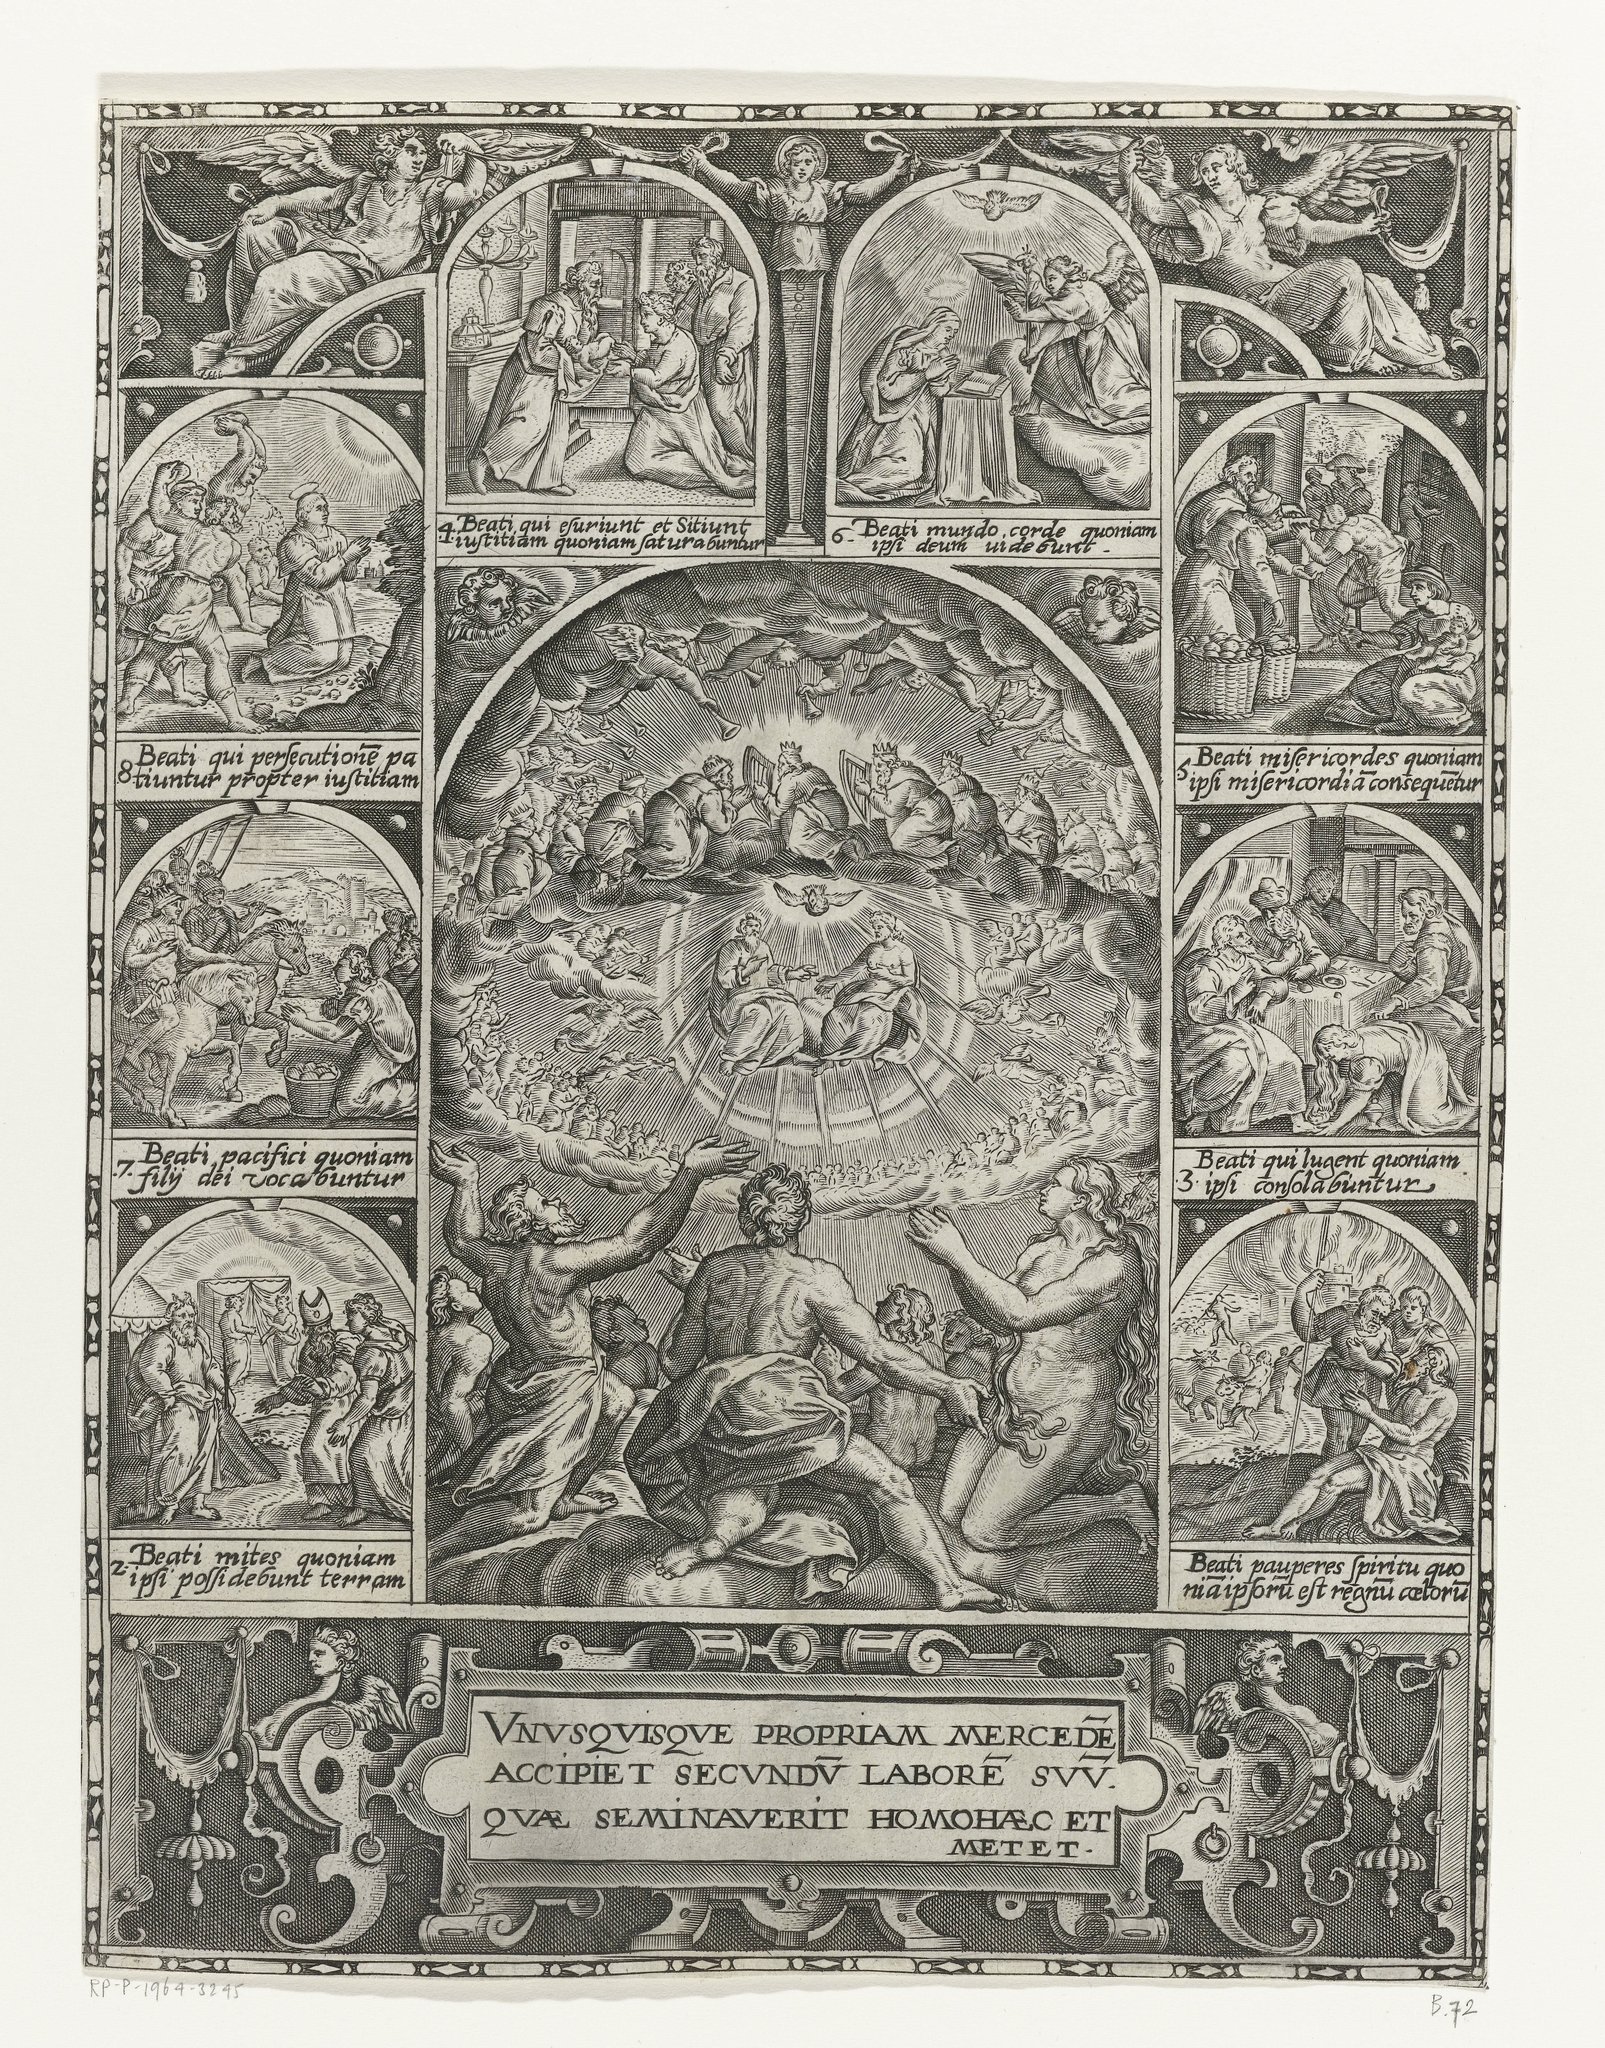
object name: print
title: Aanbidding van de heilige Drie-eenheid en de acht zaligsprekingen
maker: Anonymous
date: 1560-1599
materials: paper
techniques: engraving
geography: antwerp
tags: trinity in which god the father and christ are represented as persons, the holy ghost as dove (+ angel(s)), beatitudes of the sermon on the mount as series (matthew 5:3-12)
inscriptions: collector's mark: Lugt 2228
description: De Drie-eenheid wordt aanbeden door mensen en engelen. God de Vader en Christus zitten op een wolk, boven hen de duif van de Heilige Geest. Rond hen musicerende engelen en Oudtestamentische figuren op de wolken. De centrale voorstelling is omkaderd door genummerde scènes die de acht zaligsprekingen verbeelden. Boven: Presentatie van Christus in de tempel (nr. 4) en de Annunciatie (nr. 6). Links, van boven naar beneden: de steniging van Stefanus (nr. 8), David en Abigaïl (nr. 7) en Mozes' gezag betwist door Mirjam en Aäron (nr. 2). Rechts, van boven naar beneden: Tobit toont barmhartigheid (nr. 5), Christus gezalfd door Maria Magdalena (nr. 3) en Job hoort het slechte nieuws van vier boodschappers. Onder elke voorstelling staat de zaligspreking in het Latijn. Geheel onderaan in een cartouche een vierregelig opschrift in het Latijn.